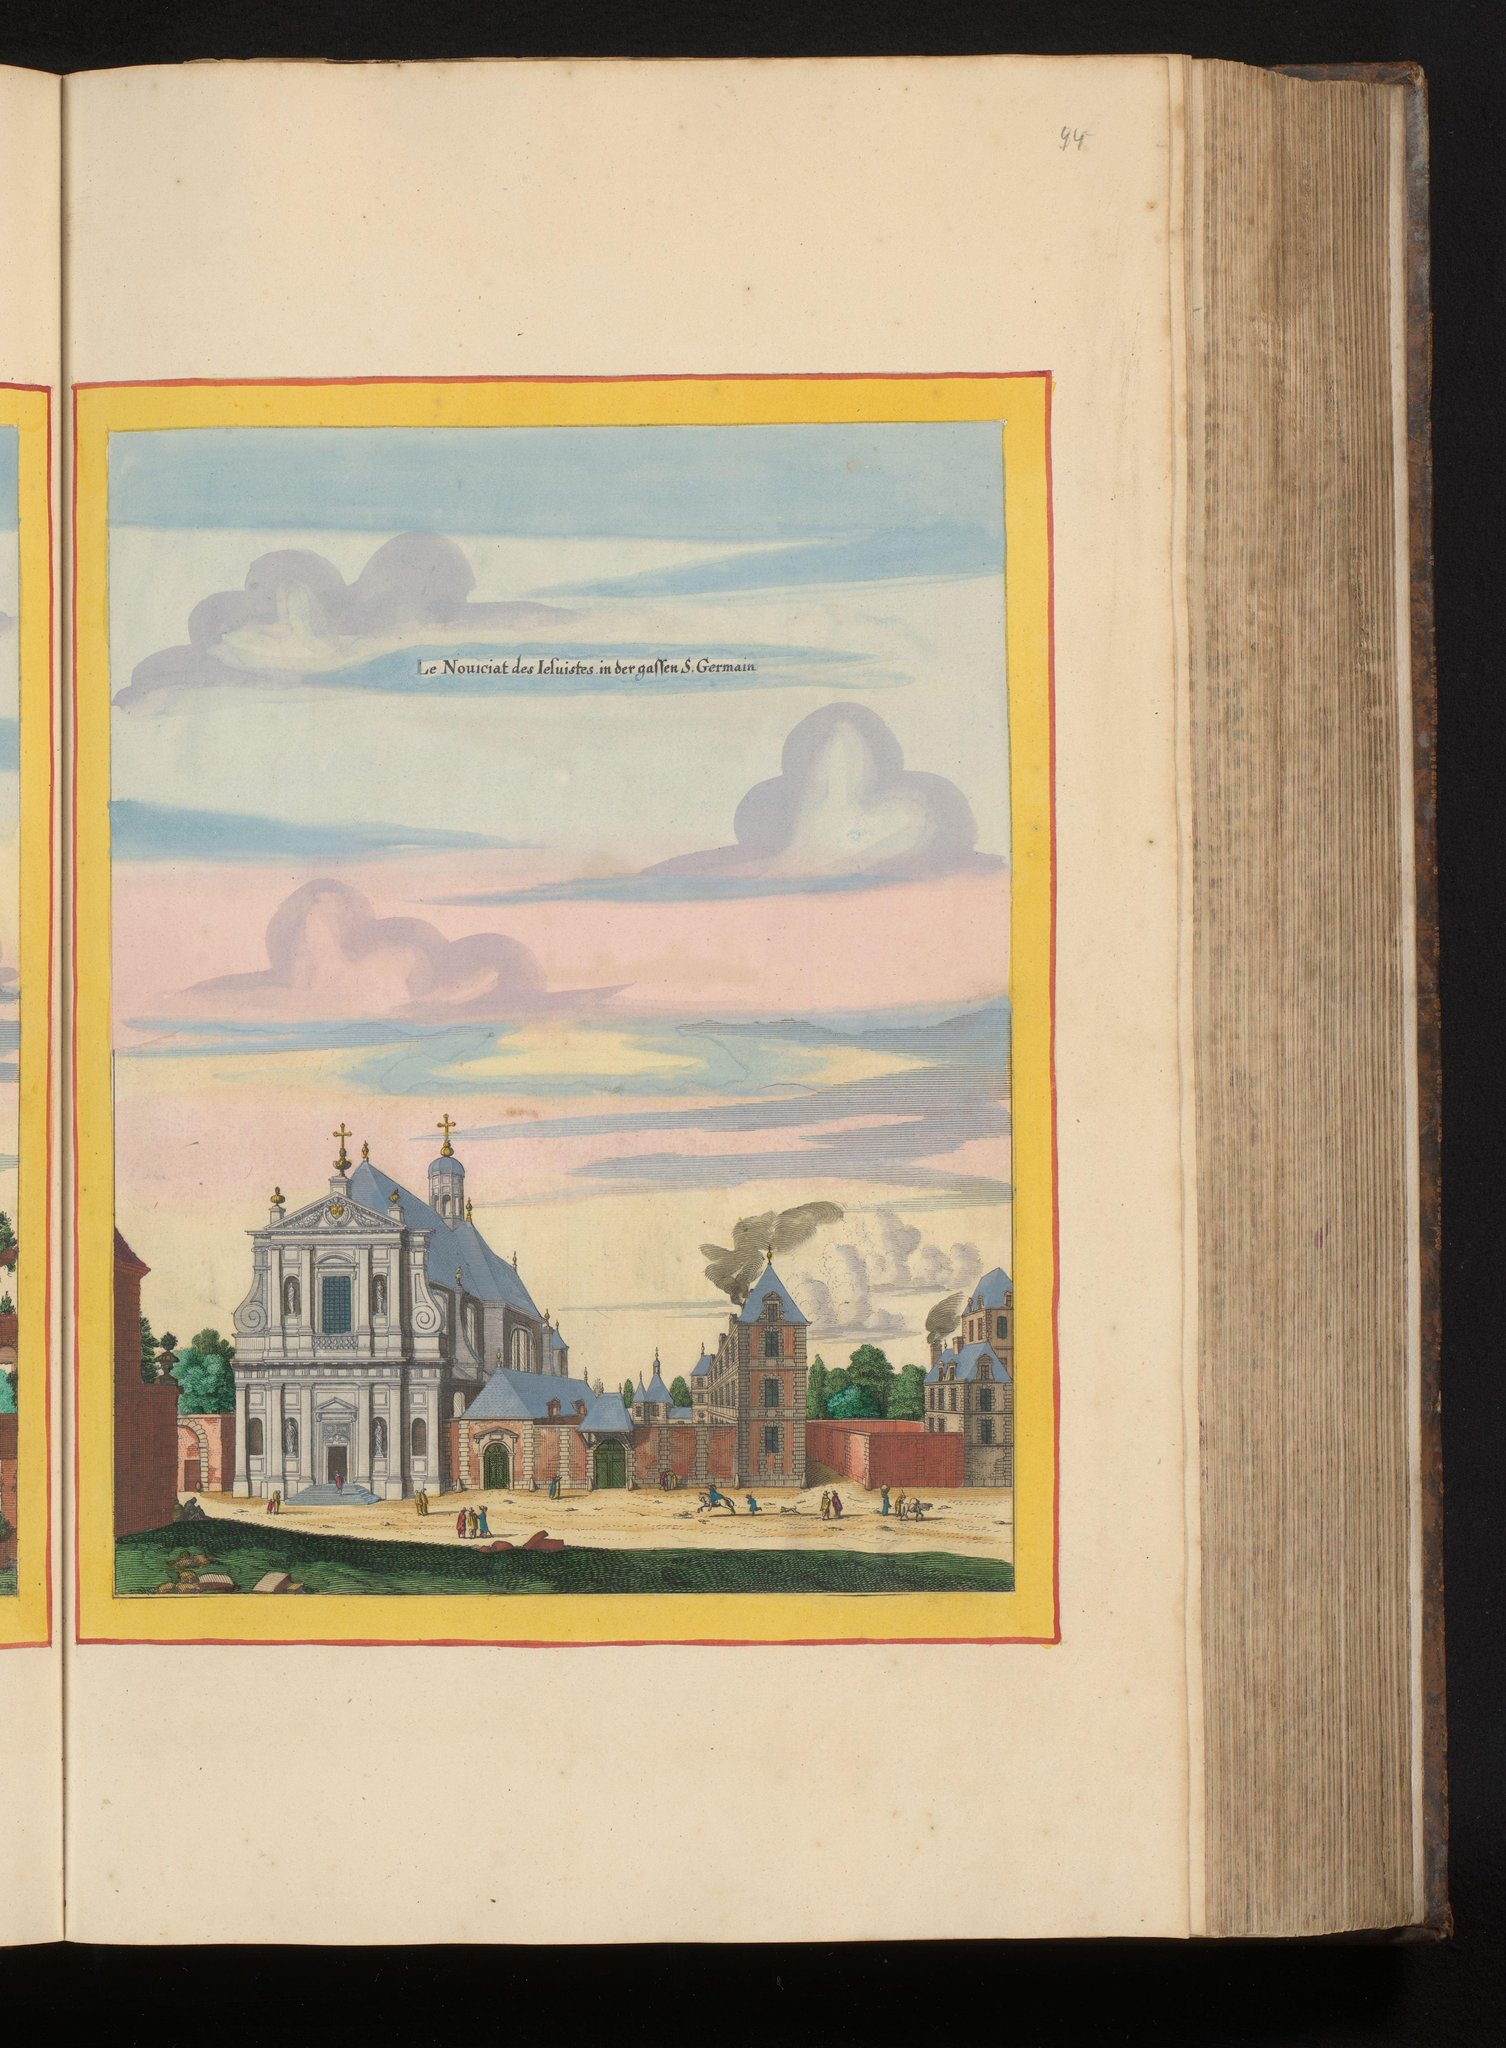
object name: print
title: Gezicht op een kerk van de Jezuiten in de rue Pot-de-Fer te Parijs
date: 1655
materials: paper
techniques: engraving, etching, hand coloring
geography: paris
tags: church (exterior)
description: Prent origineel vervaardigd als boekillustratie voor: Zeiller, Martin. Topographia Galliae, oder Beschreibung und Contrafaitung der vornehmbsten und bekantisten Oerter in dem mächtigen und grossen Königreich Frankreich, 13 delen. Frankfurt am Main: Caspar Merian, 1655-1661. De prent werd voor het eerst gepubliceerd in deel 1: Topographia Galliae, 1655.